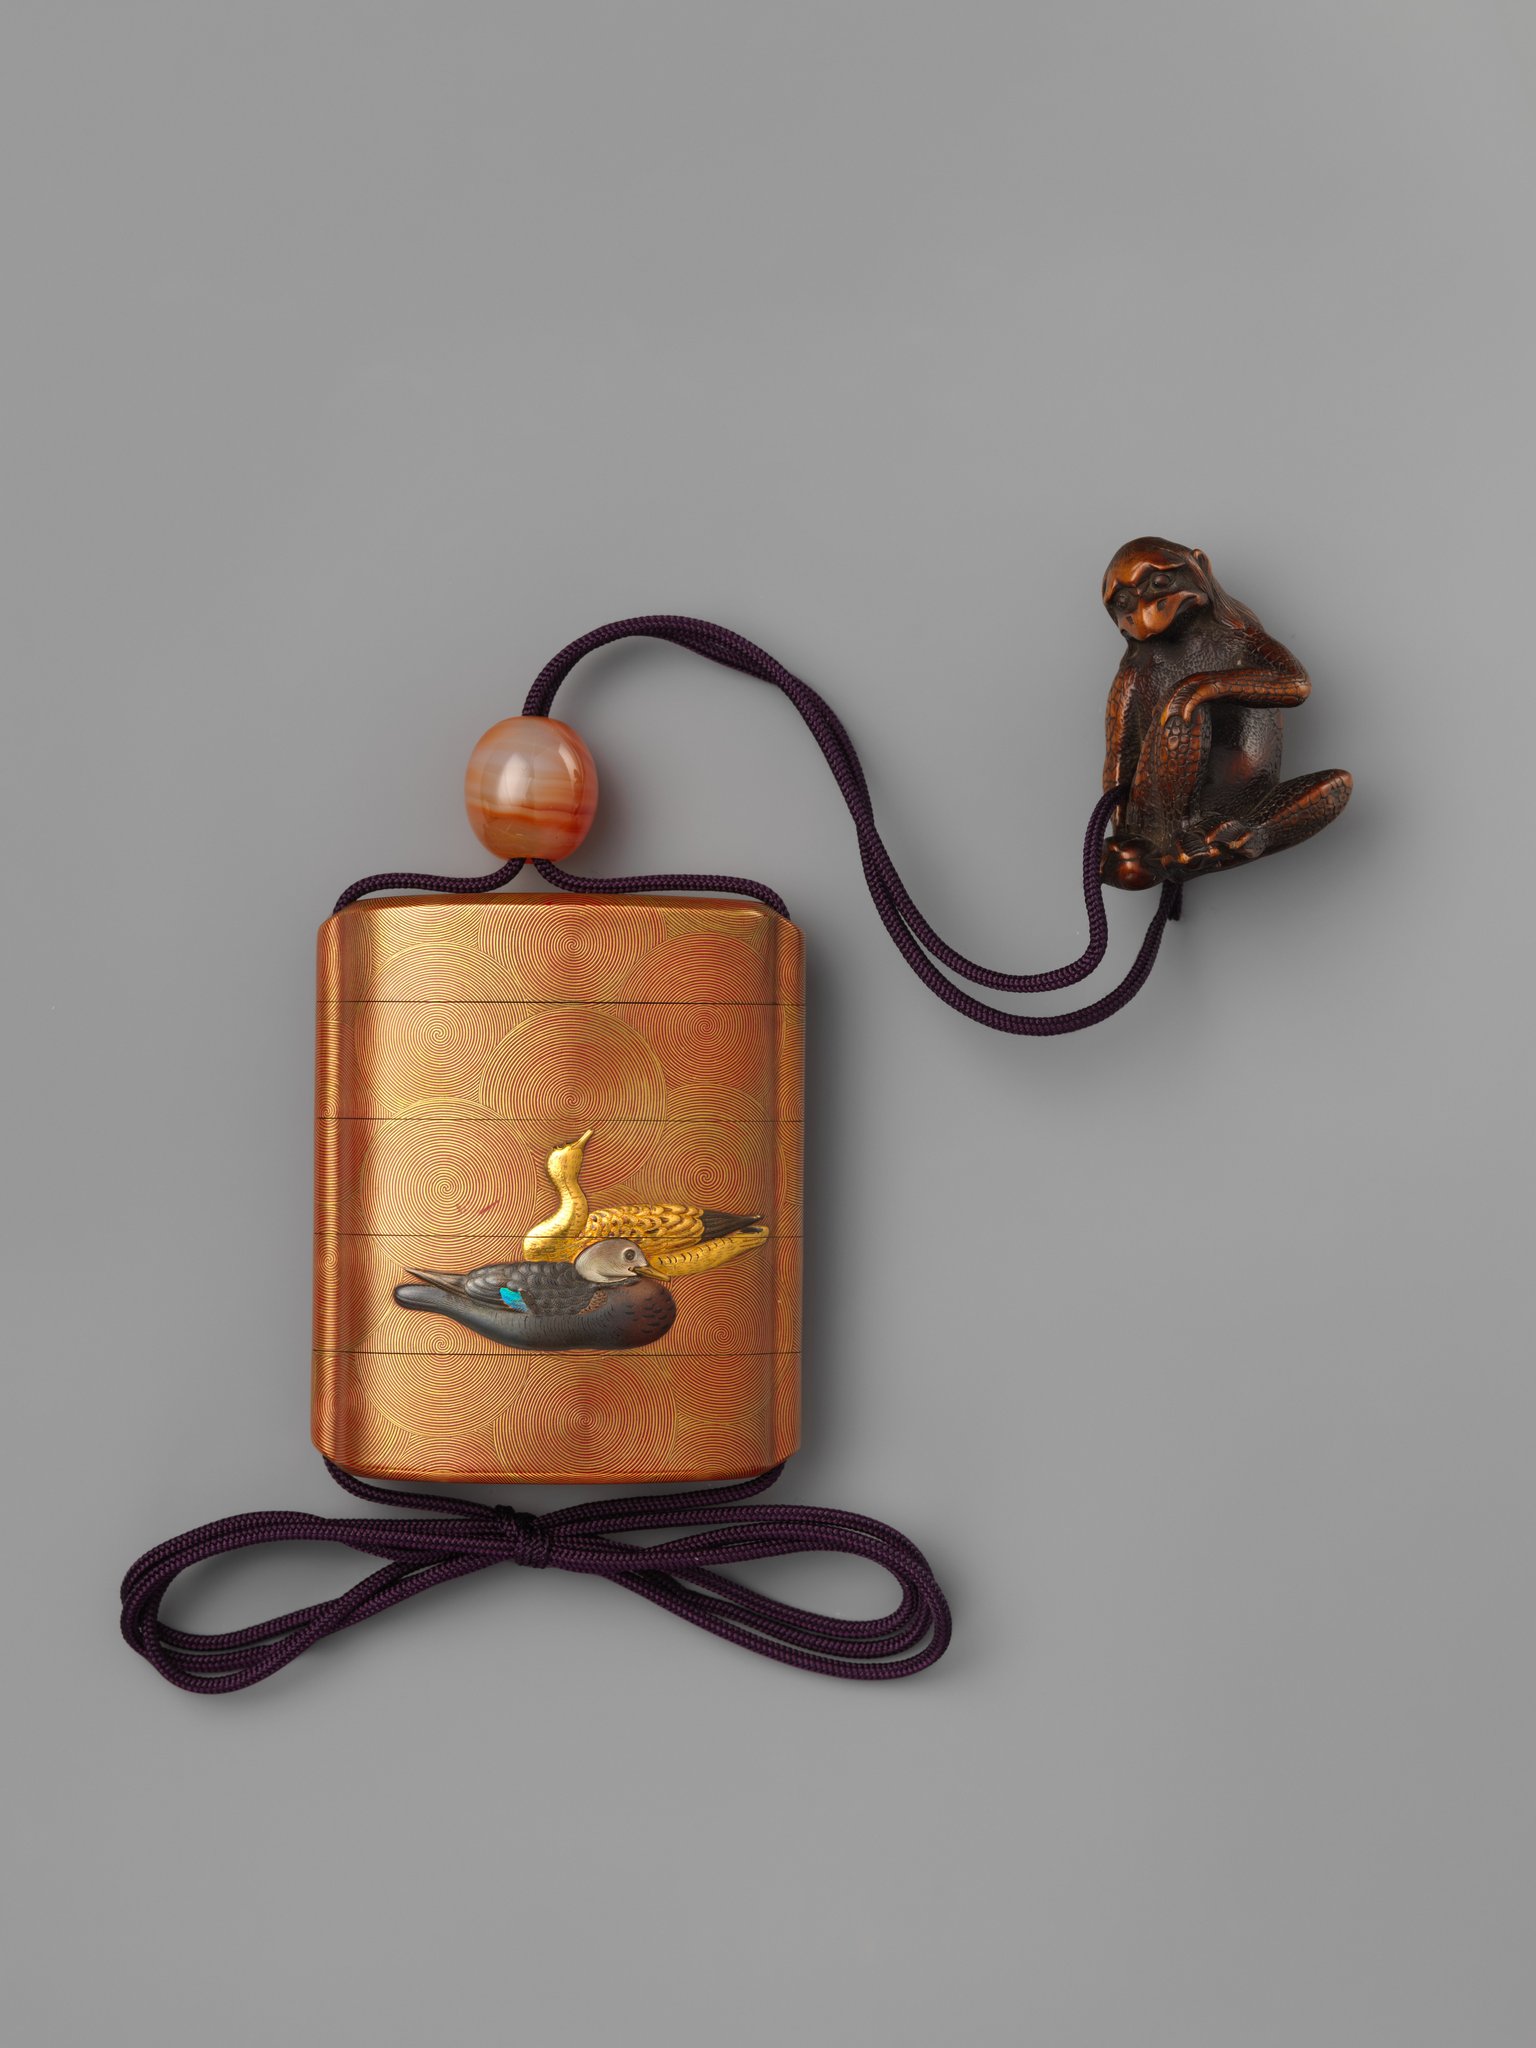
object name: inrō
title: Inrō with Ducks on Swirls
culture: japanese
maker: tōyō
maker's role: artist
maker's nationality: japanese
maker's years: 1764-1771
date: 1851-1900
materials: stone, gold, gold foil, lacquer, mother of pearl, silver, wood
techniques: carving, hiramakie, inlay, maki-e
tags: ducks